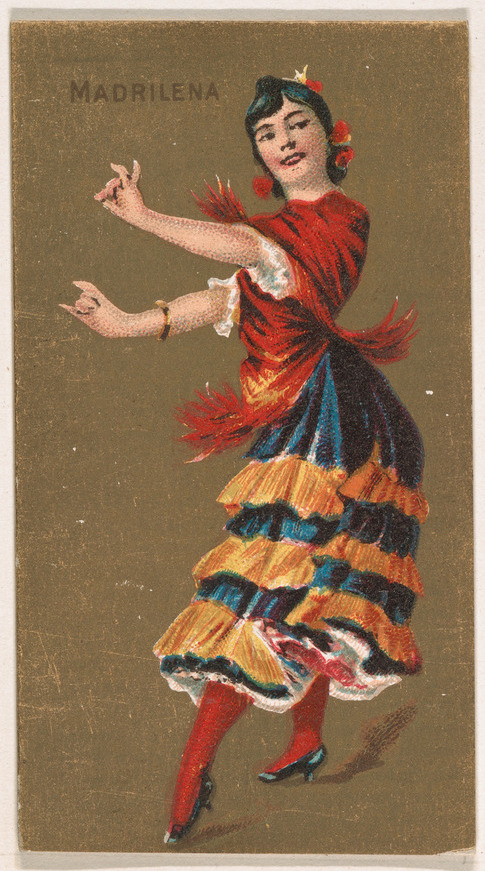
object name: print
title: Madrilena, from National Dances (N225, Type 2) issued by Kinney Bros.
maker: kinney brothers tobacco company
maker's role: publisher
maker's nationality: american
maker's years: 1869-2011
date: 1889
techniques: color lithograph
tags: women,dancing